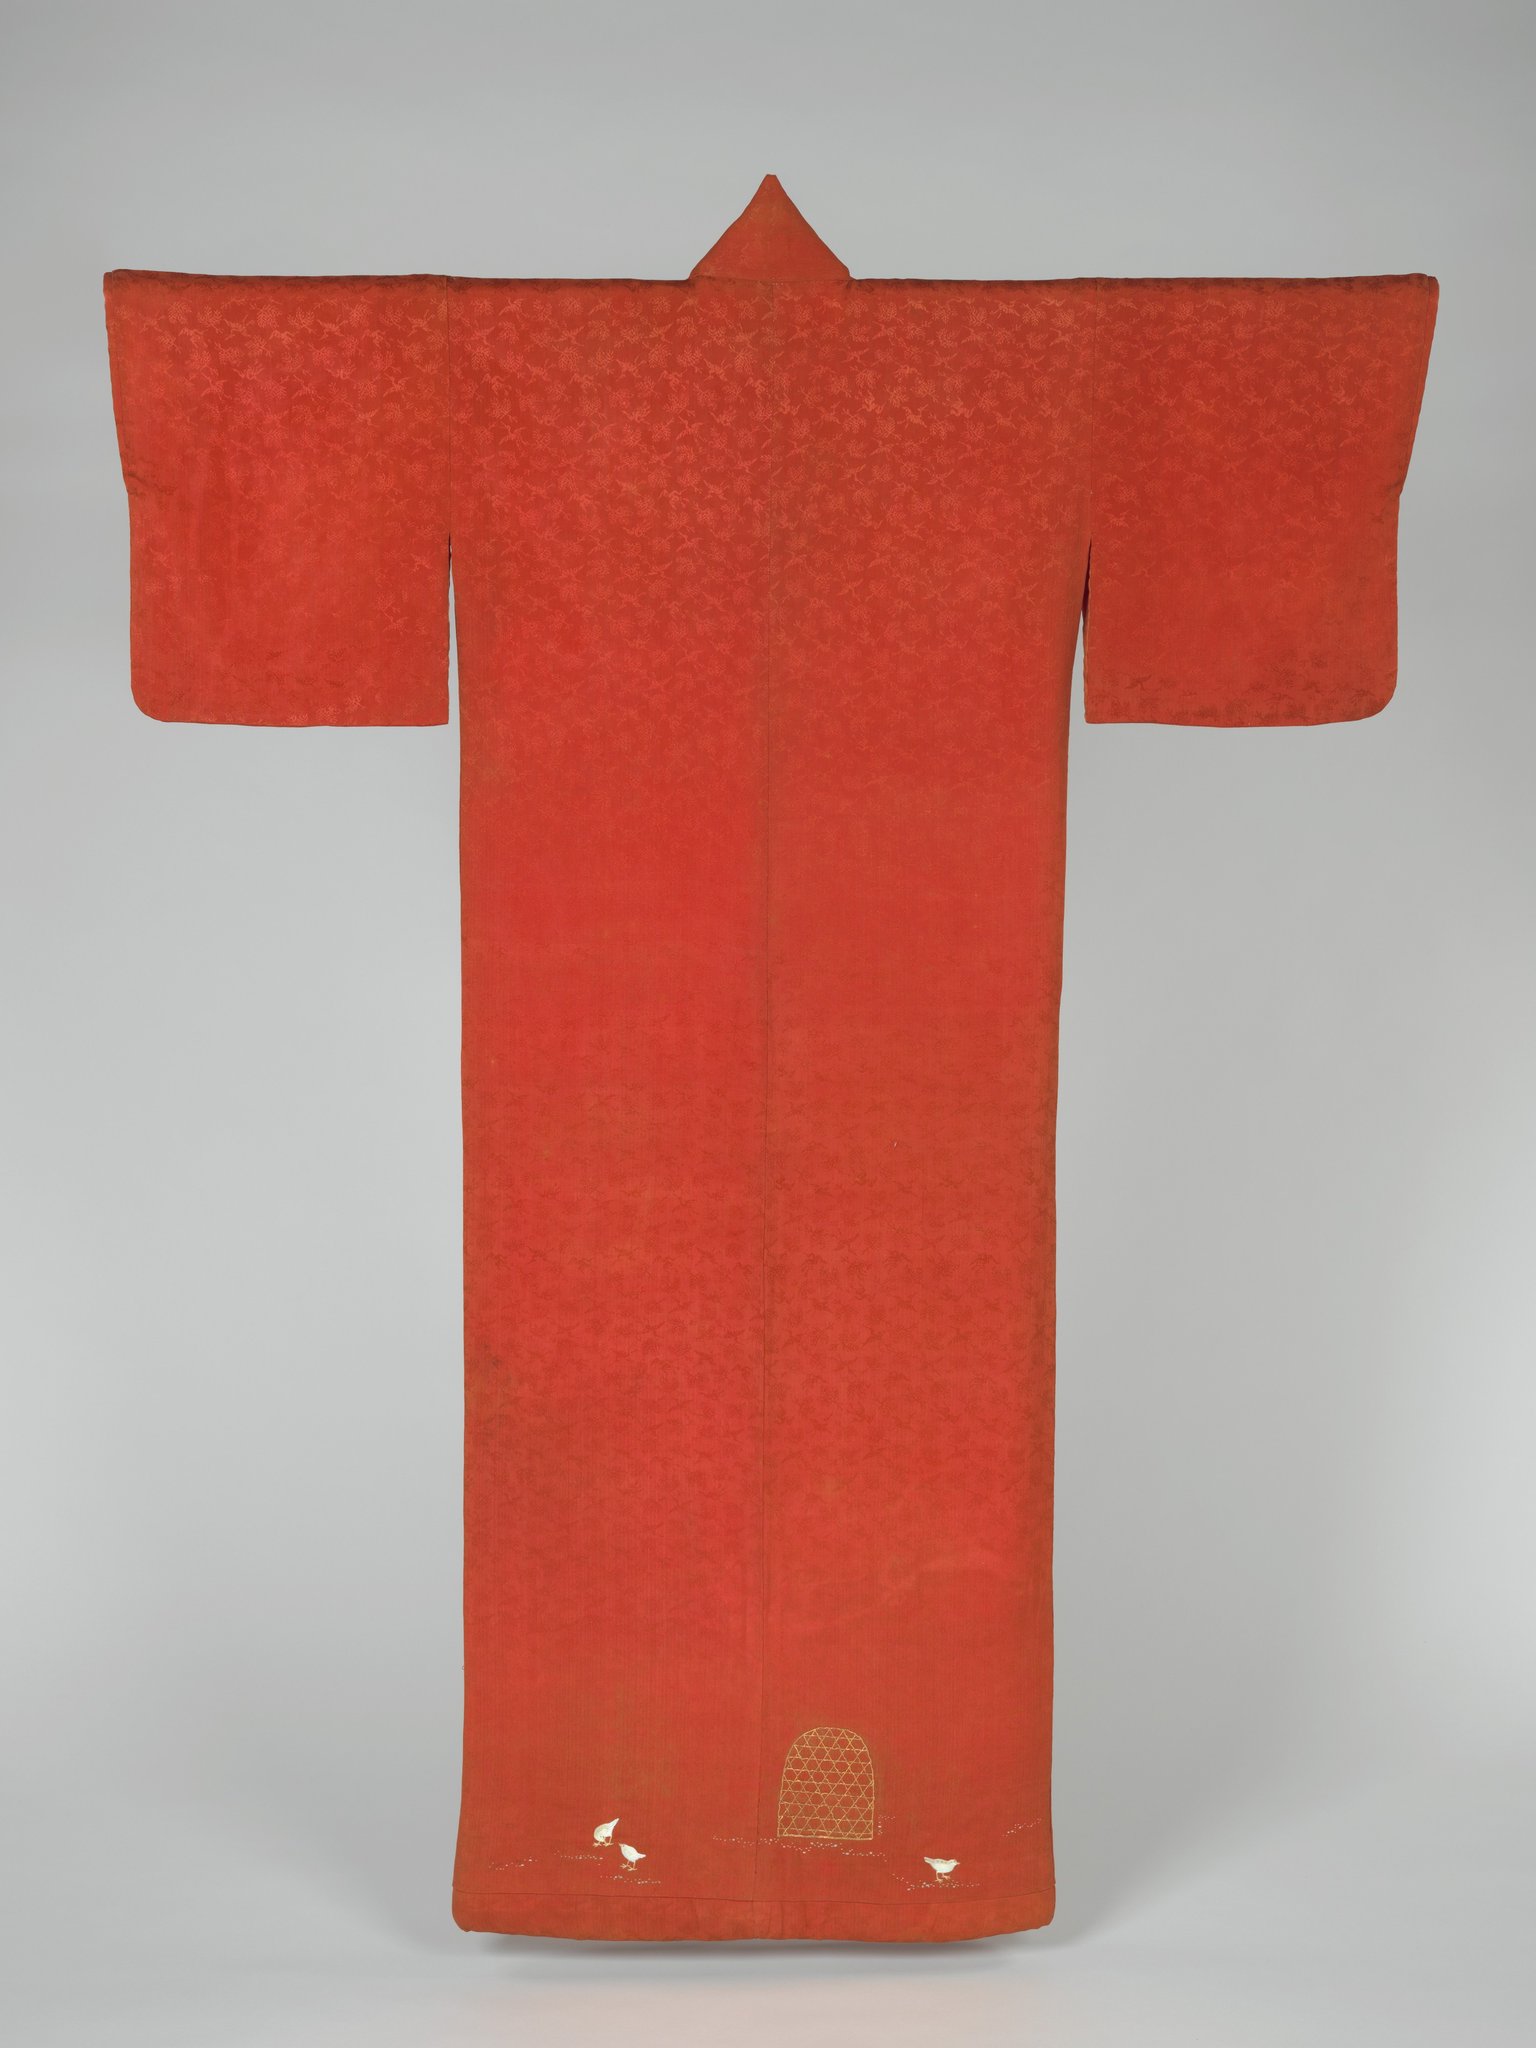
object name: kosode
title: Kosode Robe with Roosters and Hens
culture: japanese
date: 1801-1900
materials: metal thread, silk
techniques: embroidery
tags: chickens,roosters